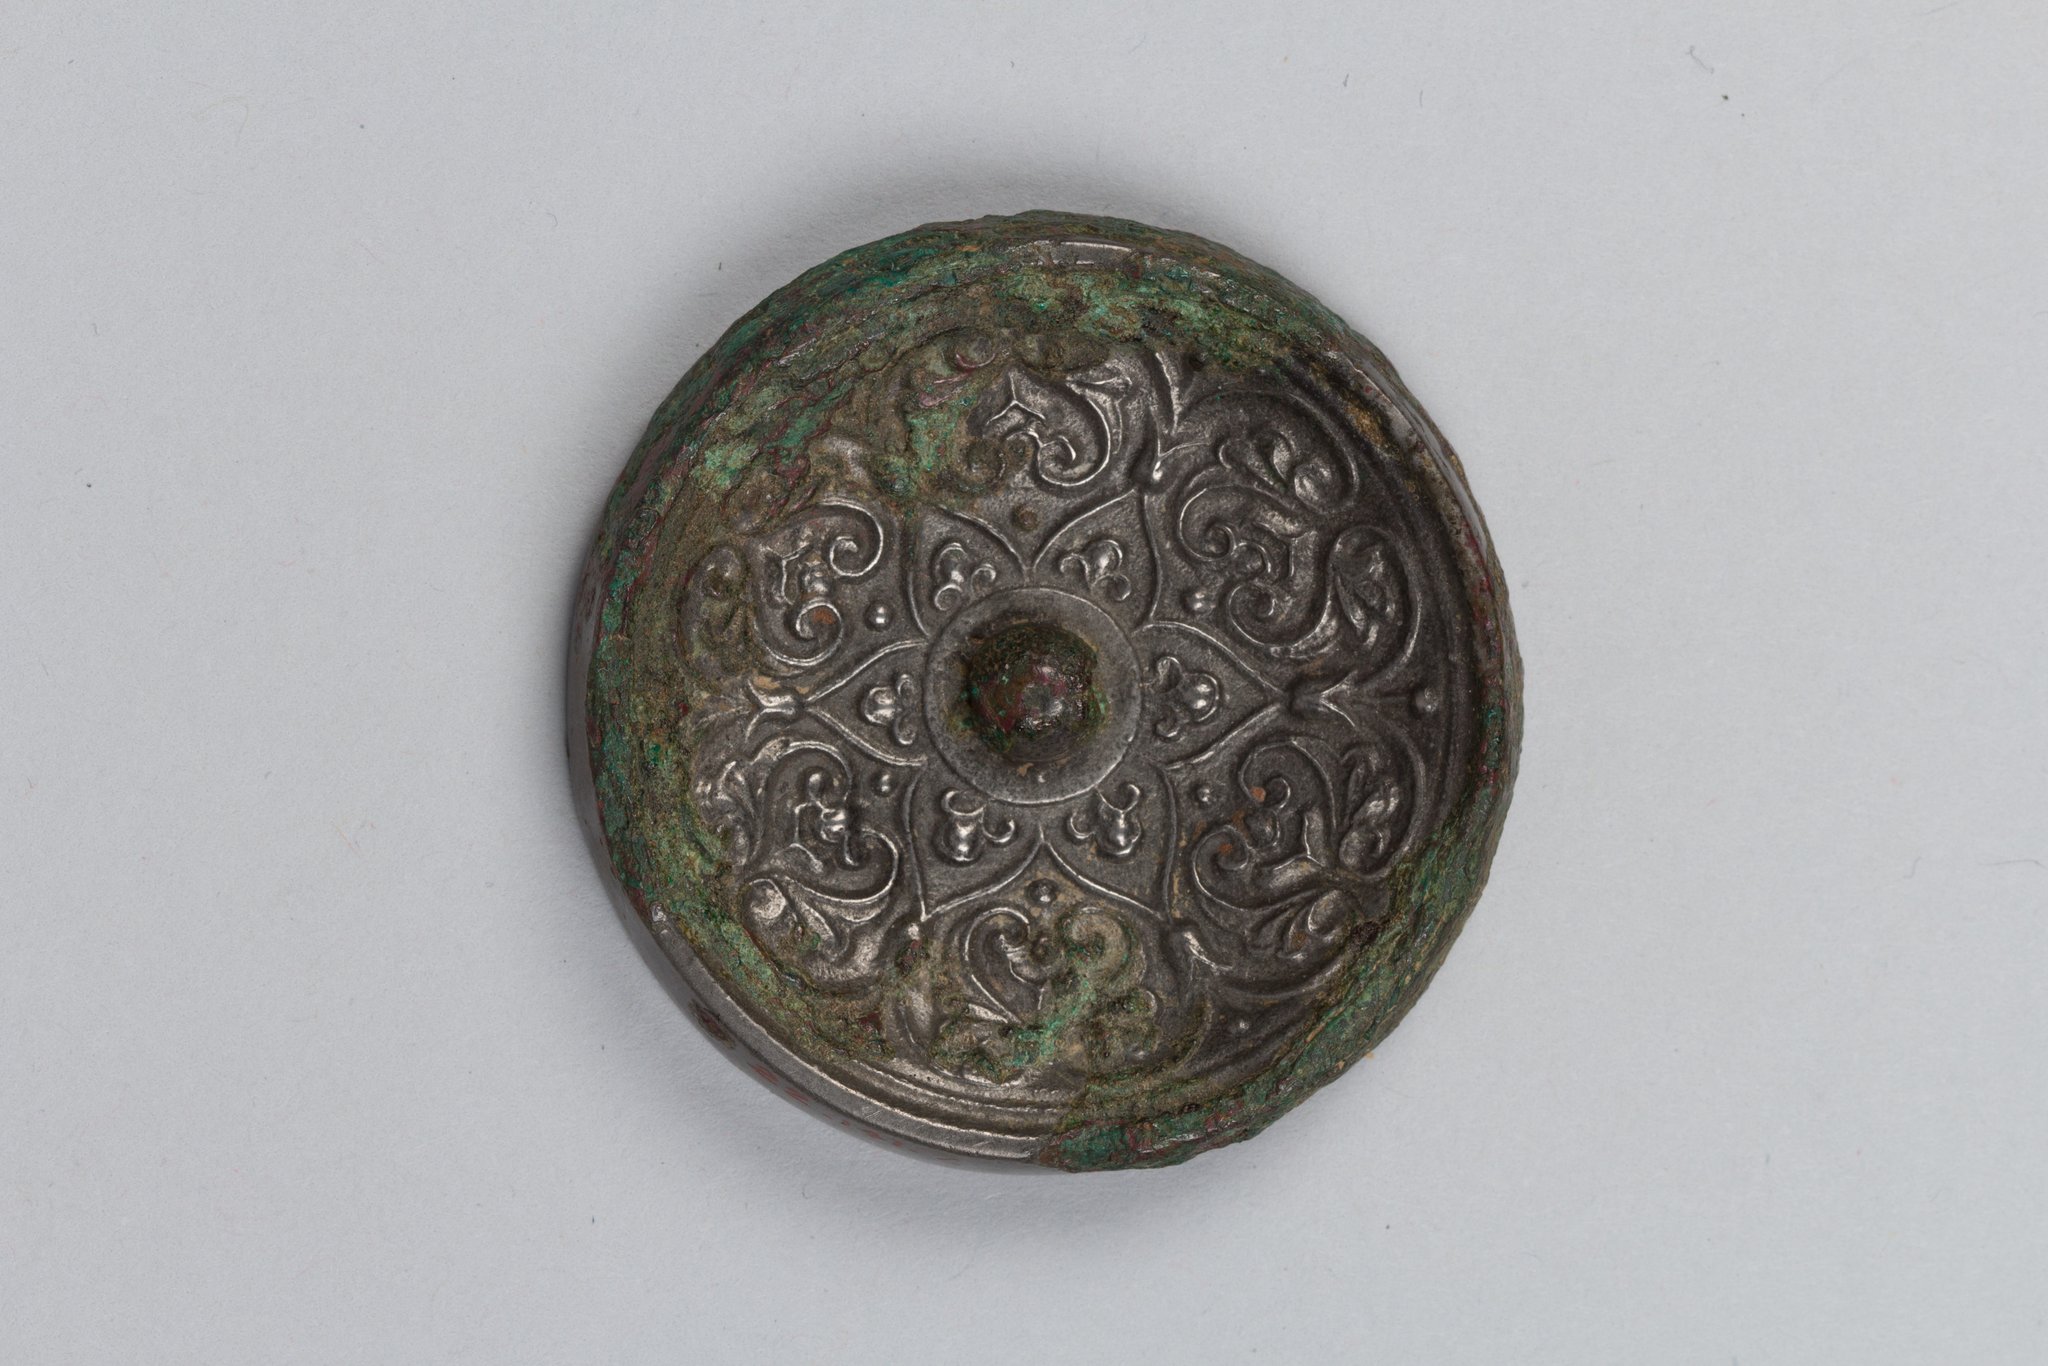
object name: mirror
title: Mirror with floral patterns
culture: chinese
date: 701-800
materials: bronze